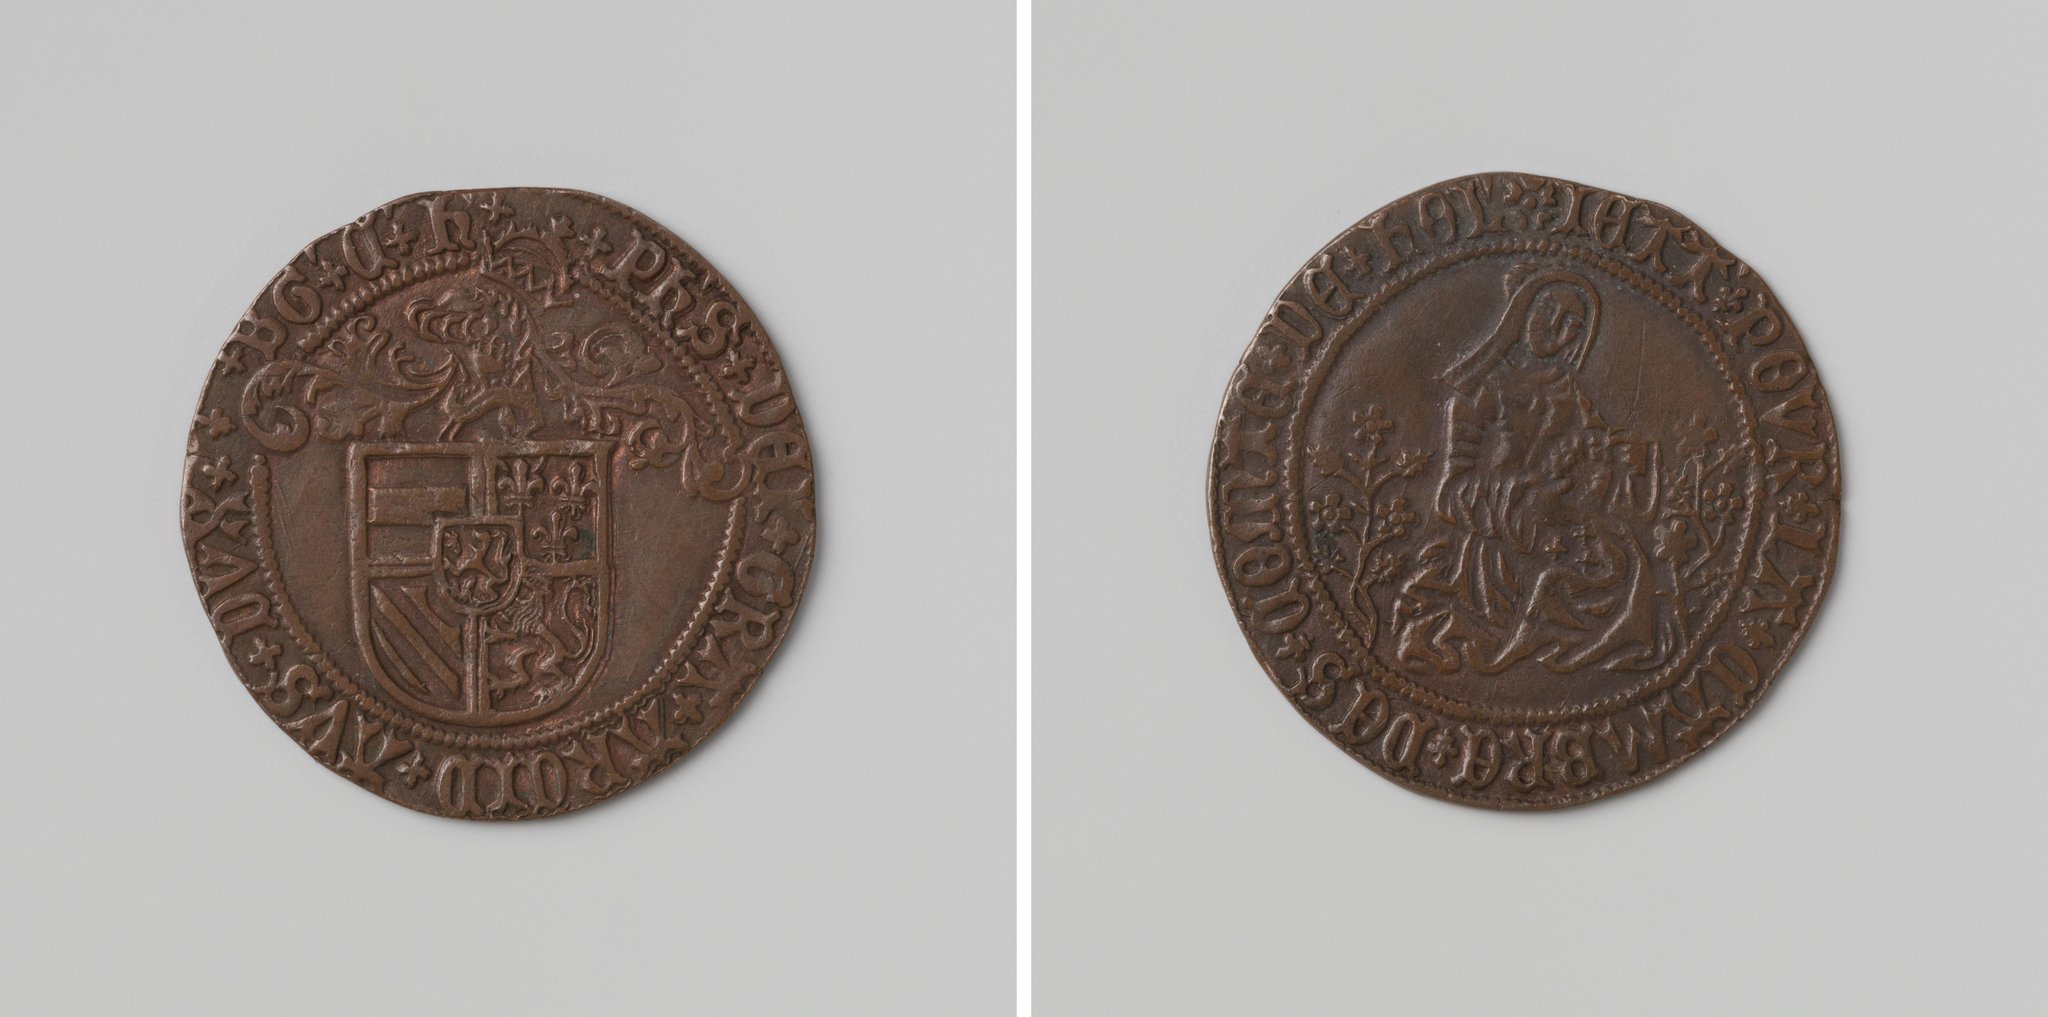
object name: medal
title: Philips de Schone, hertog van Bourgondië, ingehuldigd als graaf van Holland, rekenpenning van de rekenkamer van Holland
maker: Anonymous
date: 1497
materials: copper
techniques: striking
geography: netherlands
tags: filips de schone (hertog van bourgondië), county of holland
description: Koperen penning. Voorzijde: wapenschild onder gekroonde helm binnen omschrift. Keerzijde: vrouw met muts, zittend temidden van bloeiende rozen binnen omschrift